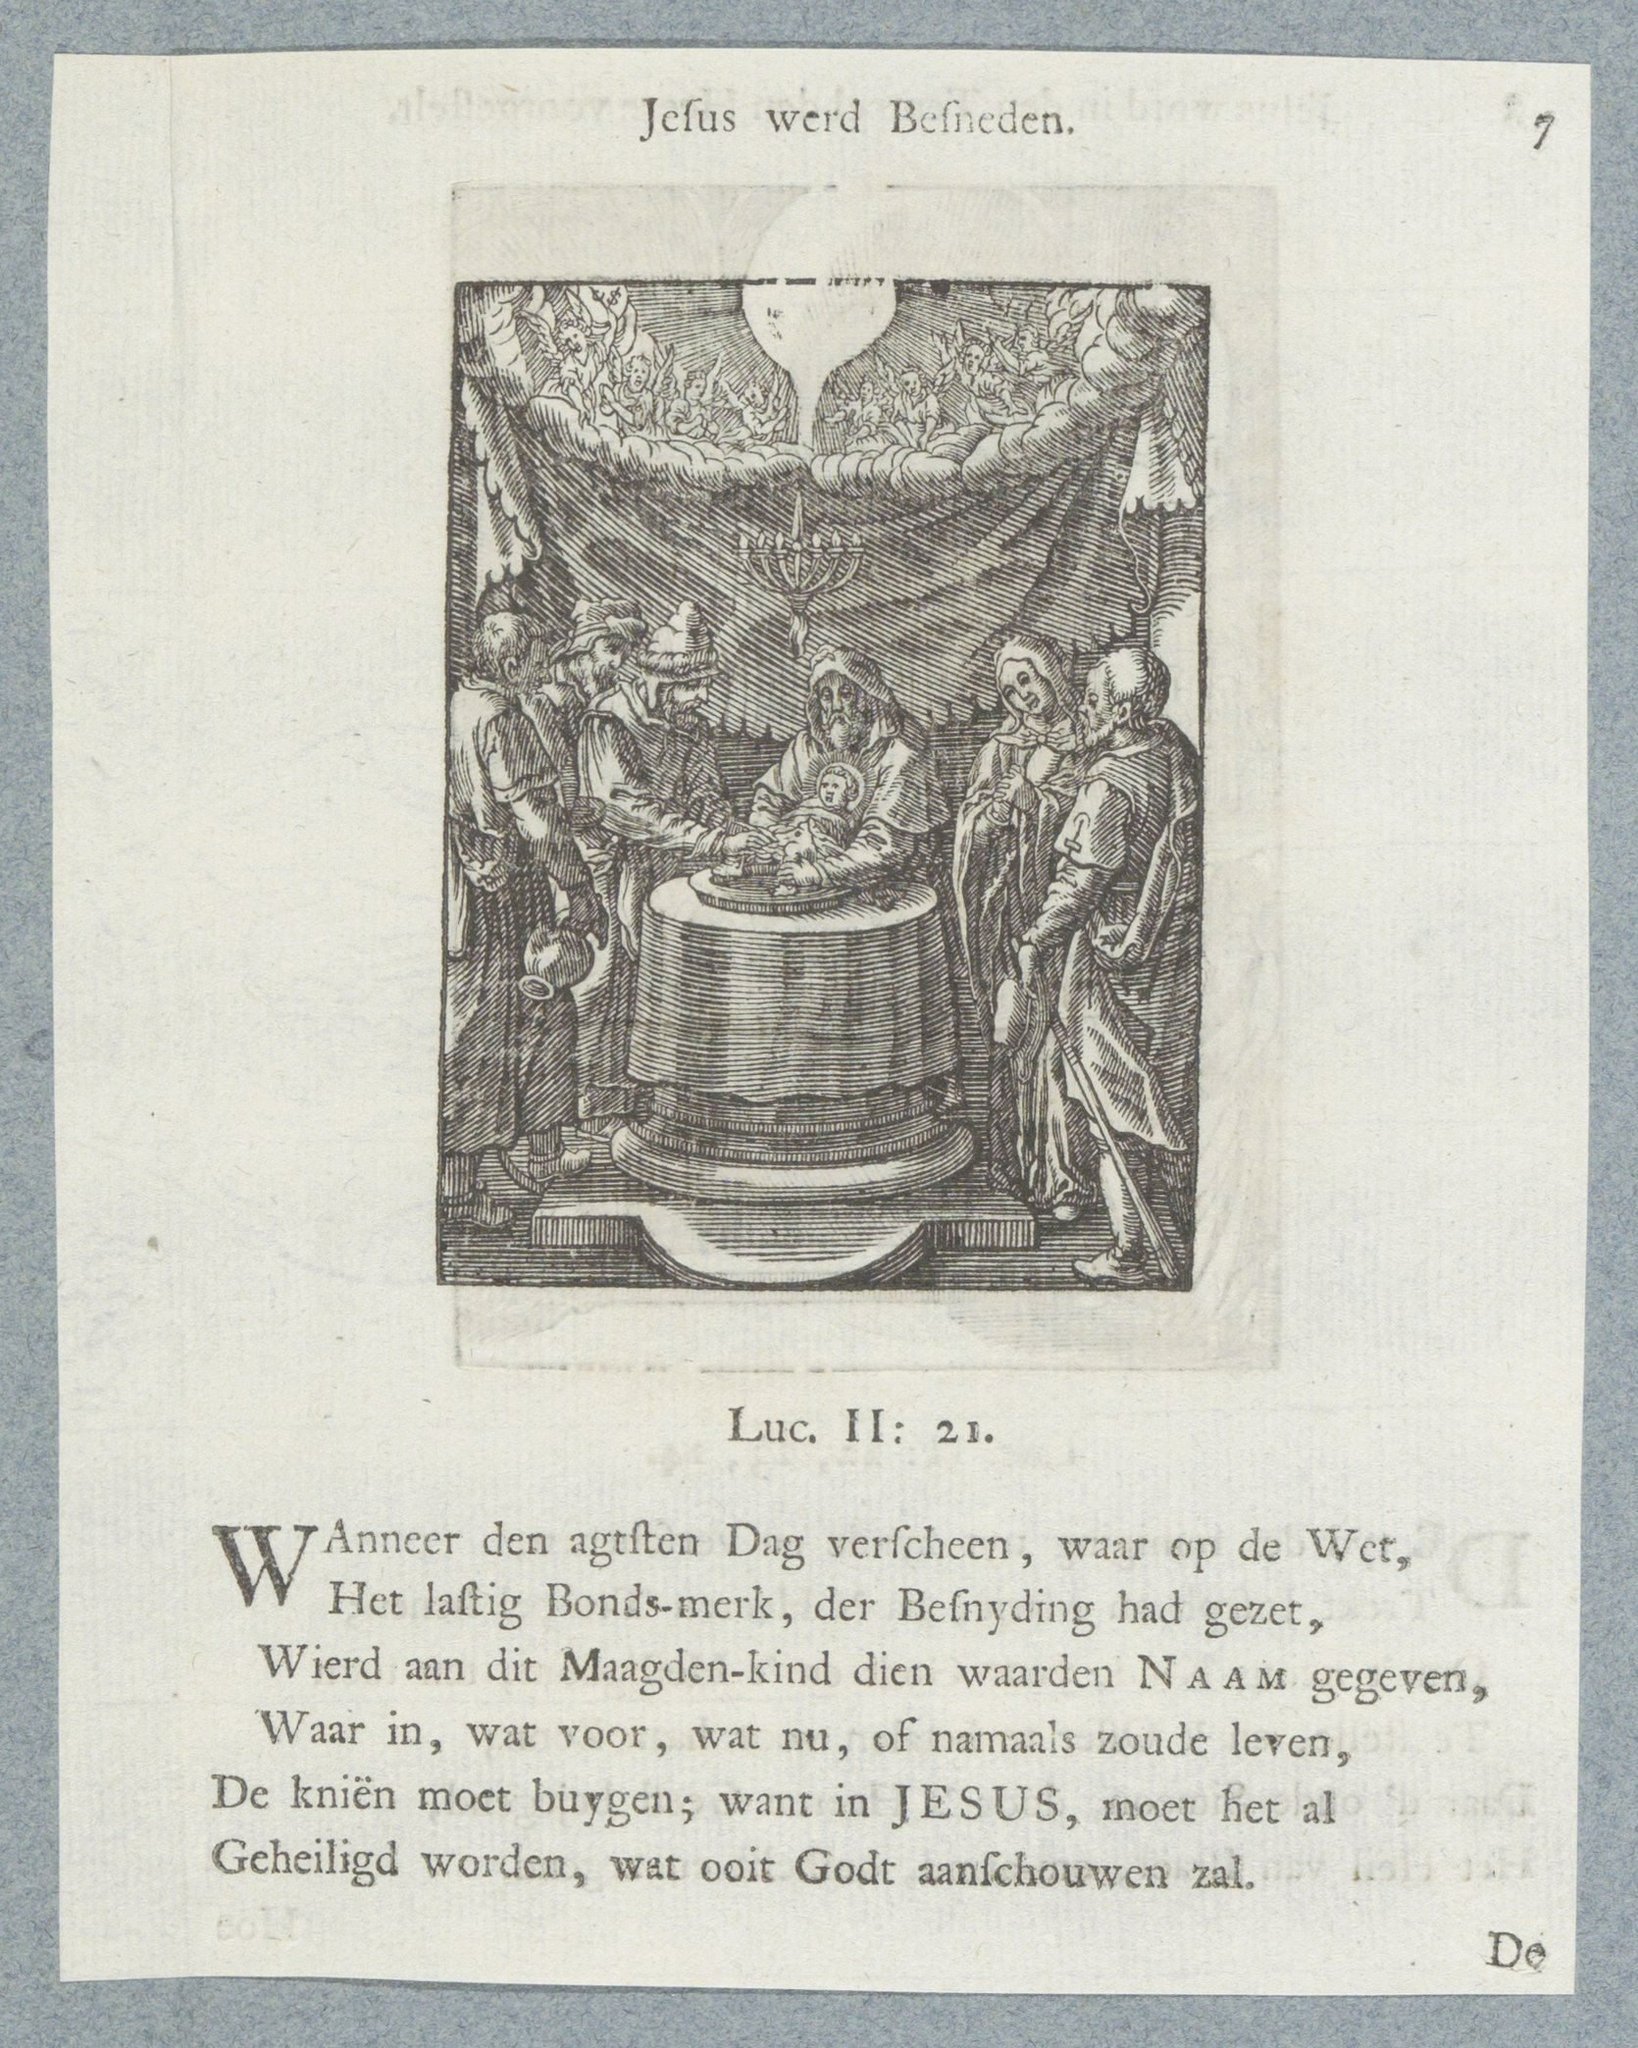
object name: album leaf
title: Jesus werd besneden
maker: jan klooster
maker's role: bookseller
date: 1629-1648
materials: paper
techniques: letterpress printing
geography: antwerp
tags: circumcision of the christ-child by the priest in the temple (luke 2:21)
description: Van deze prenten zijn twee staten bekend. Op deze tweede staat is de afbeelding van de Heilige Geest in de vorm van een duif van de voorstelling verwijderd. De prent is afkomstig uit: Bybels Lusthof. Amsterdam, J. Klooster, 1740. De prent werd gemaakt voor de uitgaven van P.J. Paets uit Amsterdam, verschenen in de jaren 1629-1648.